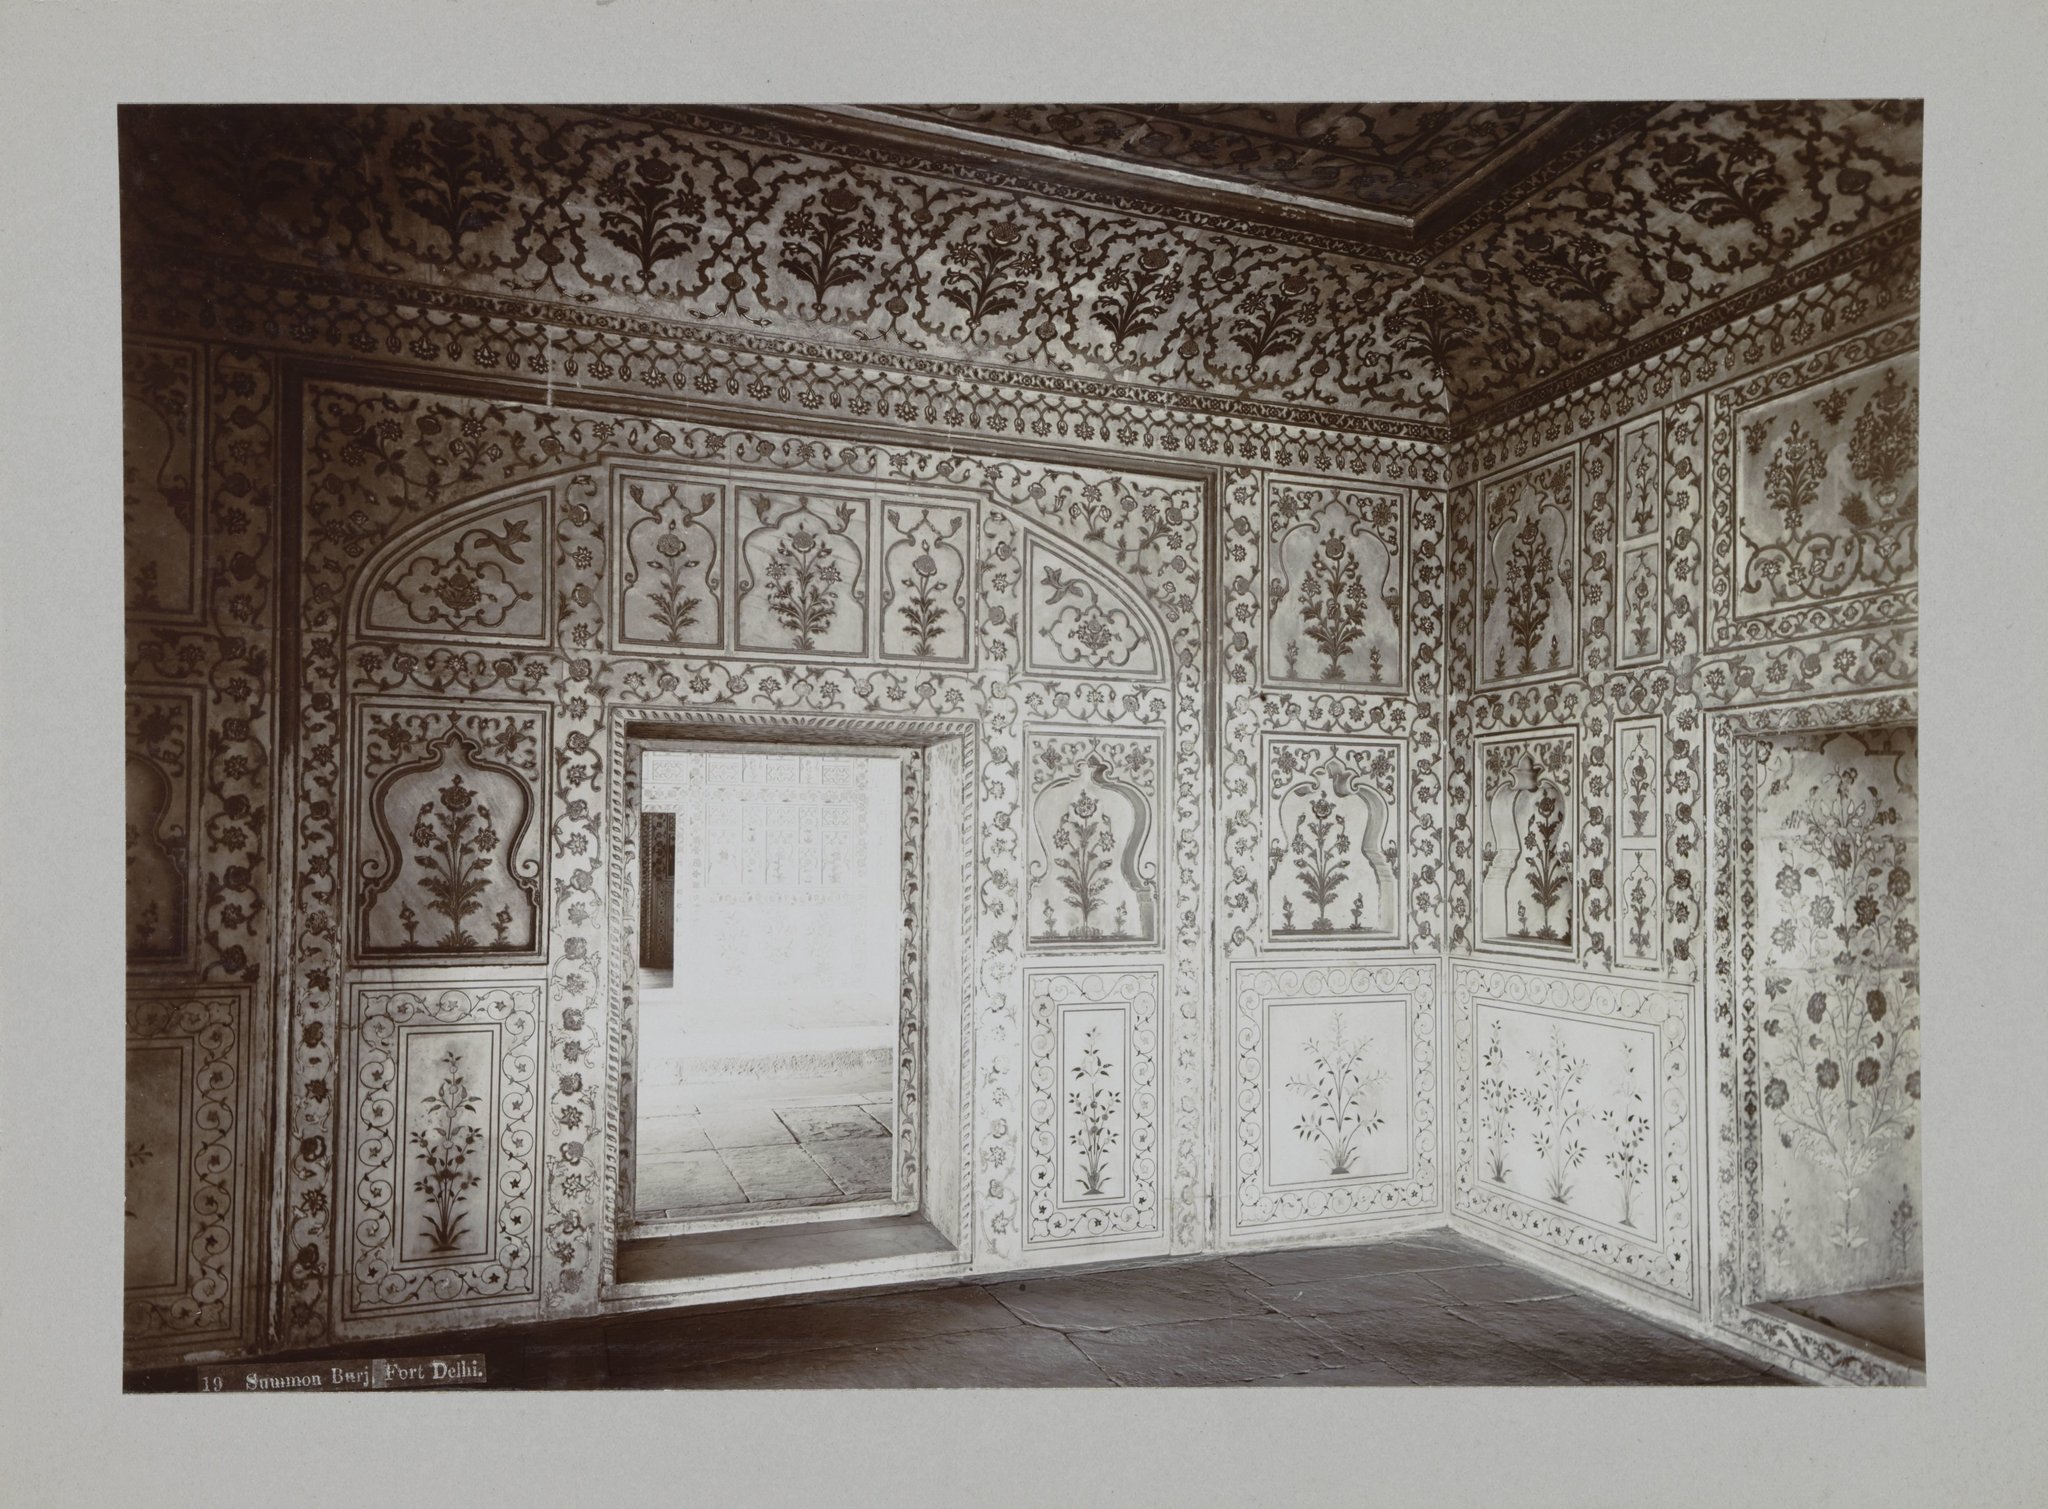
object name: photograph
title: Room within the Red Fort at Delhi, India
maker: Anonymous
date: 1895-1915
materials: cardboard, paper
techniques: gelatin silver print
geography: delhi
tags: delhi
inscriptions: inscription: ‘19 Summon Burj, Fort Delhi.’, number: ‘28.’